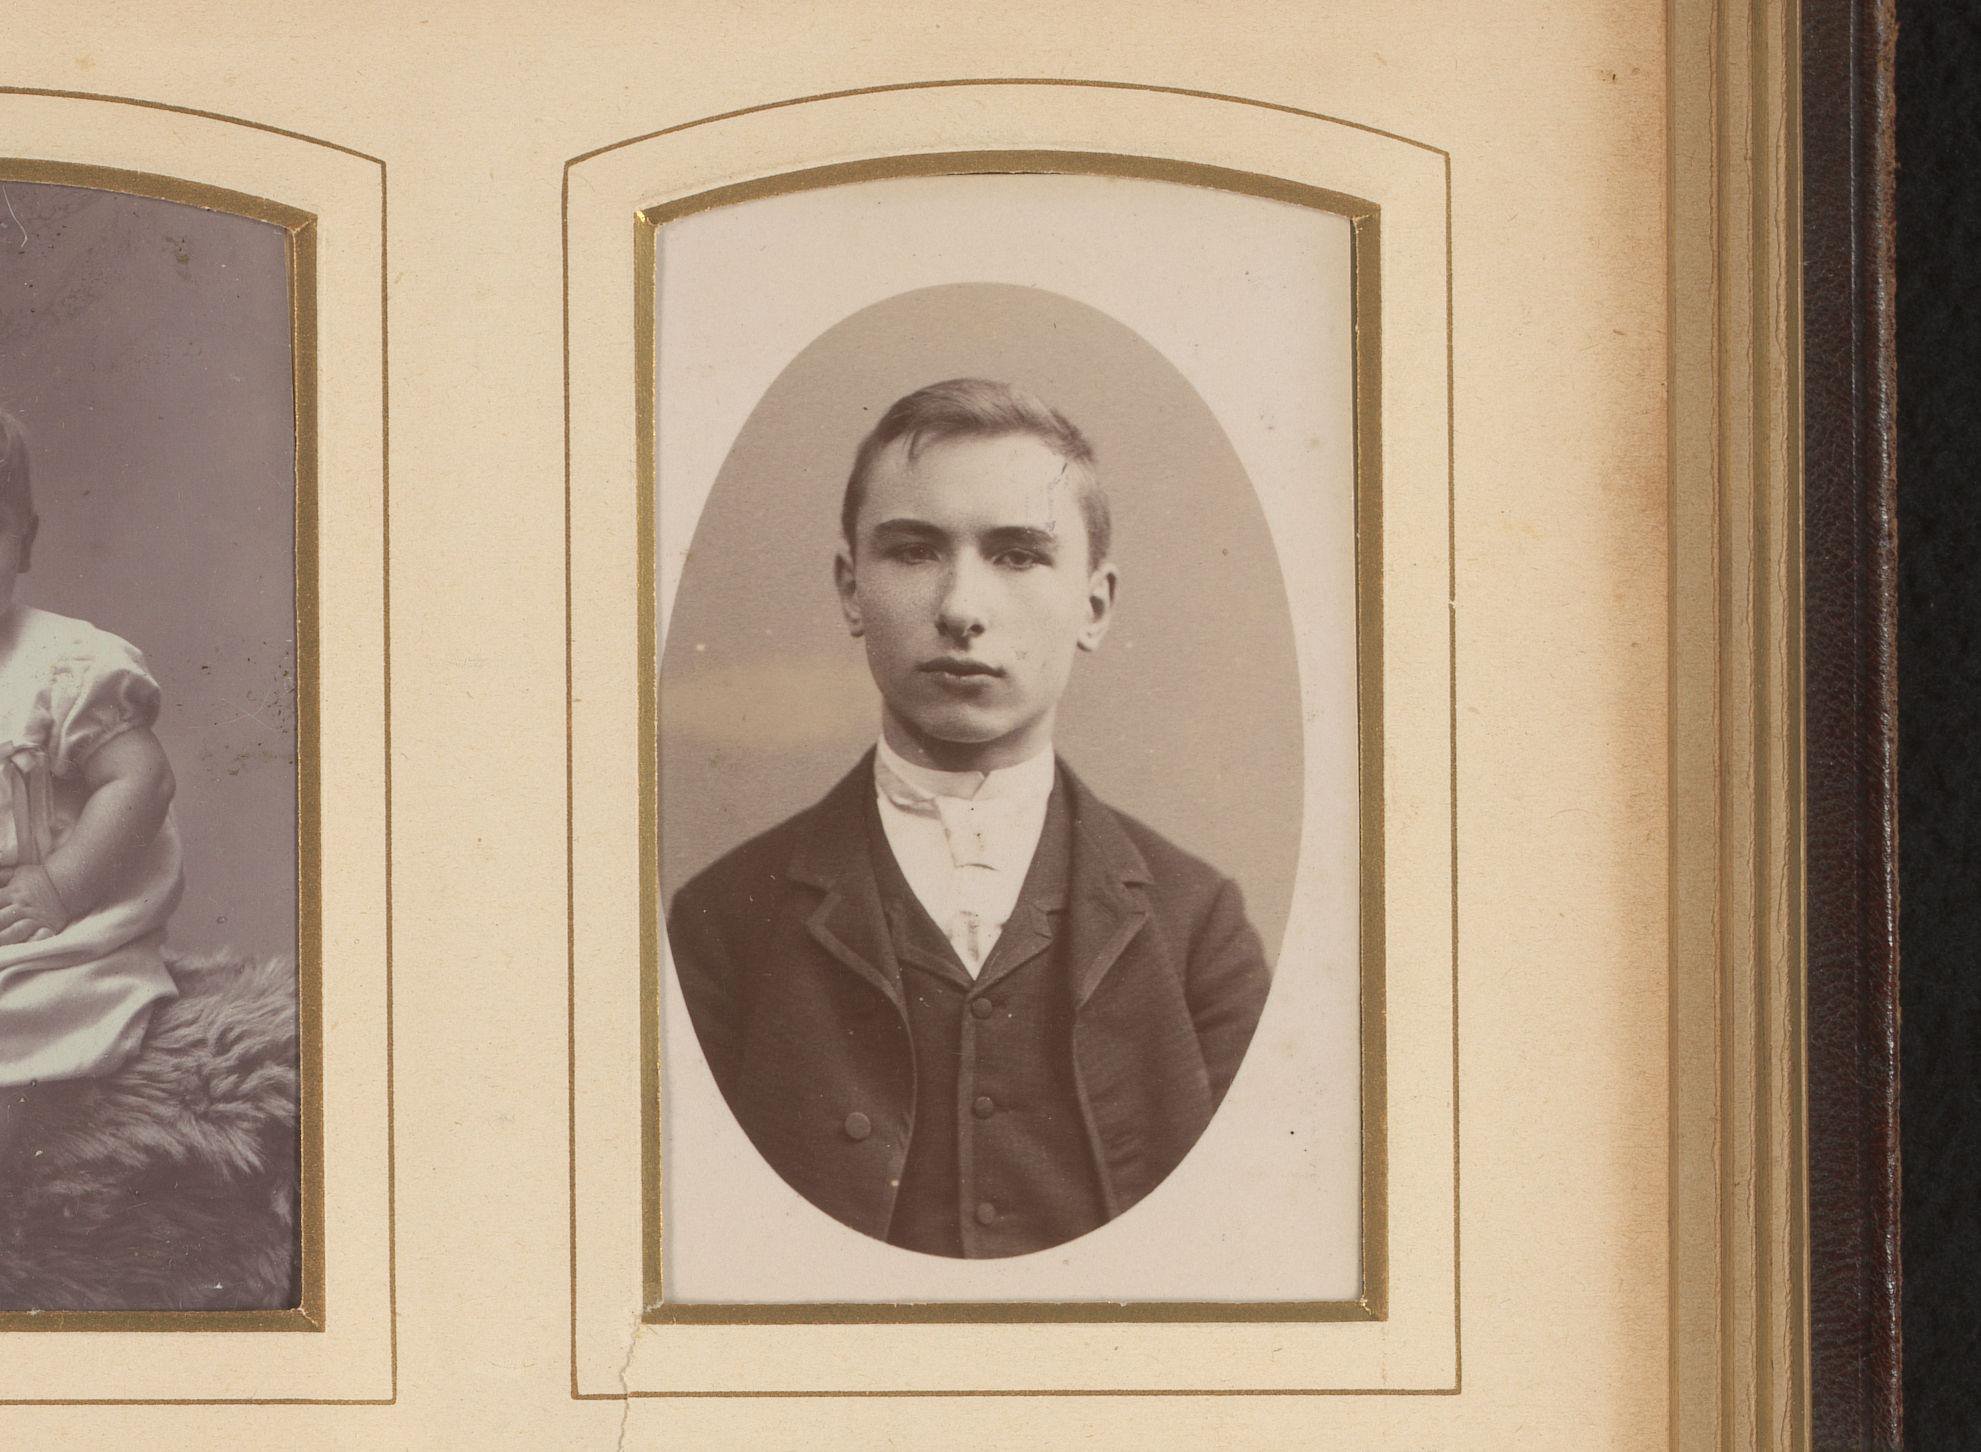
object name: carte de visite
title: Portret van een jongen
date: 1887-1890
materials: cardboard, photographic support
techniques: albumen print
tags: boy (child between toddler and youth), historical persons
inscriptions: inscription: ‘Photografische Inrigting/ van/ Jacques Chits/ Haarlem/ Nassaustraat/ No. 14./ Amsterdam/ Plantage/ Kerklaan No. 15/ over de Koningskroon./ De plaat blijft ter nabestelling bewaard.’